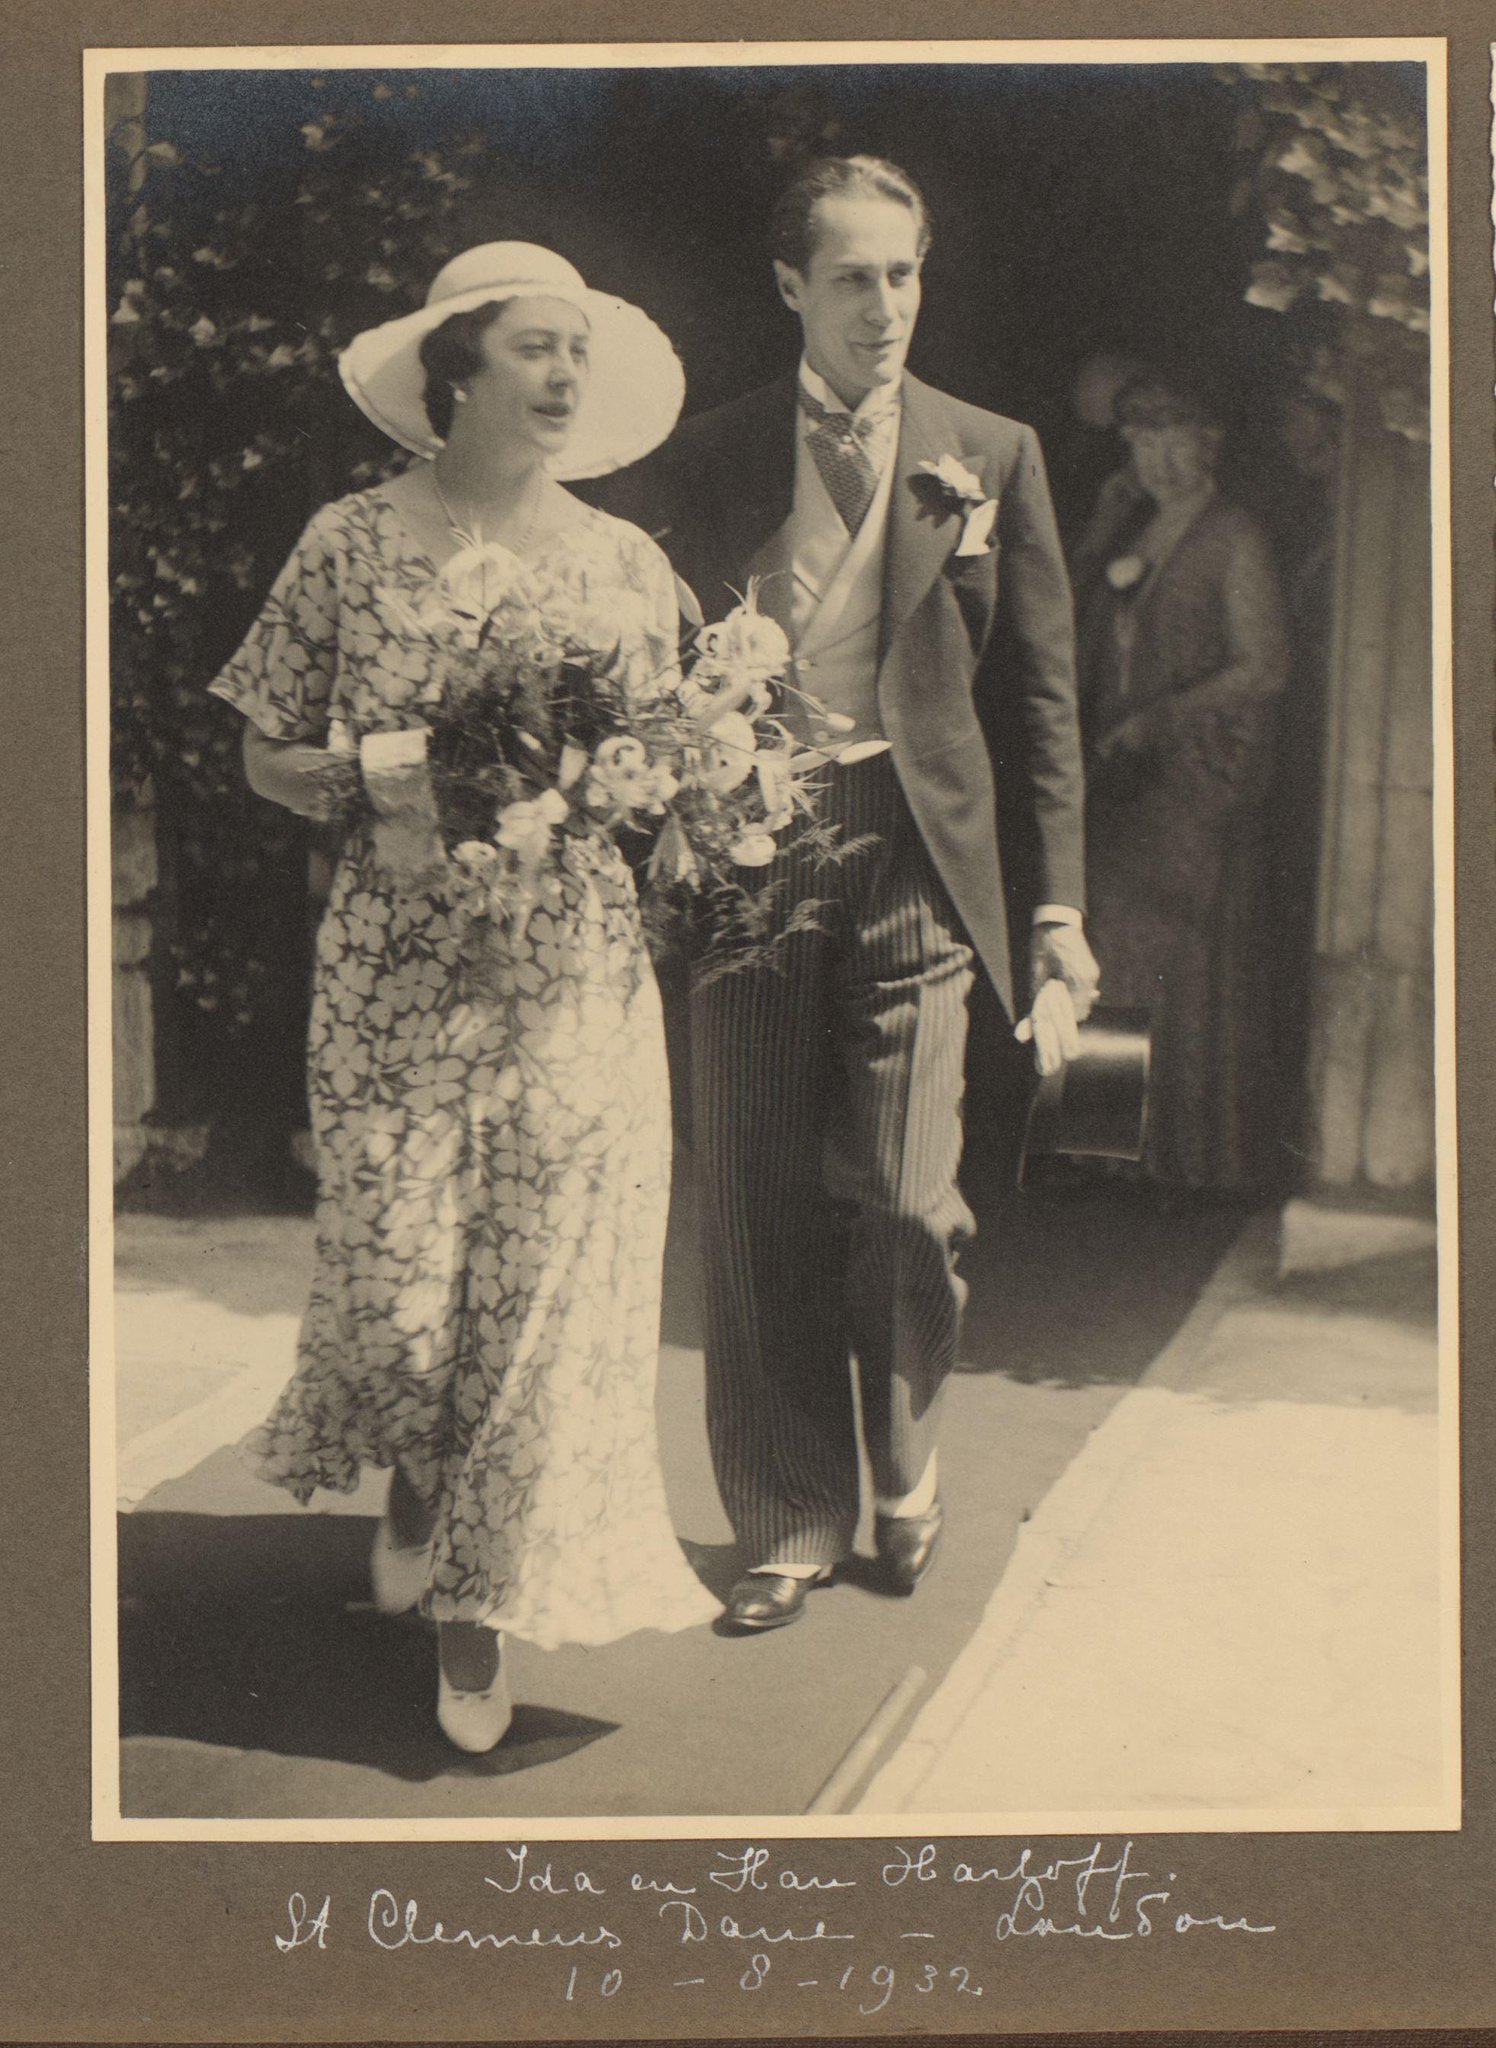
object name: photograph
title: Ida-Teresa Conti en Han Harloff op hun bruiloft, Londen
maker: Anonymous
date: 1932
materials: paper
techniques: gelatin silver print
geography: london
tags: the hague, bride and groom in wedding-dress, london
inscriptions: inscription: ‘Ida en Han Harloff/ St Clemens Dane - London/ 10-8-1932’